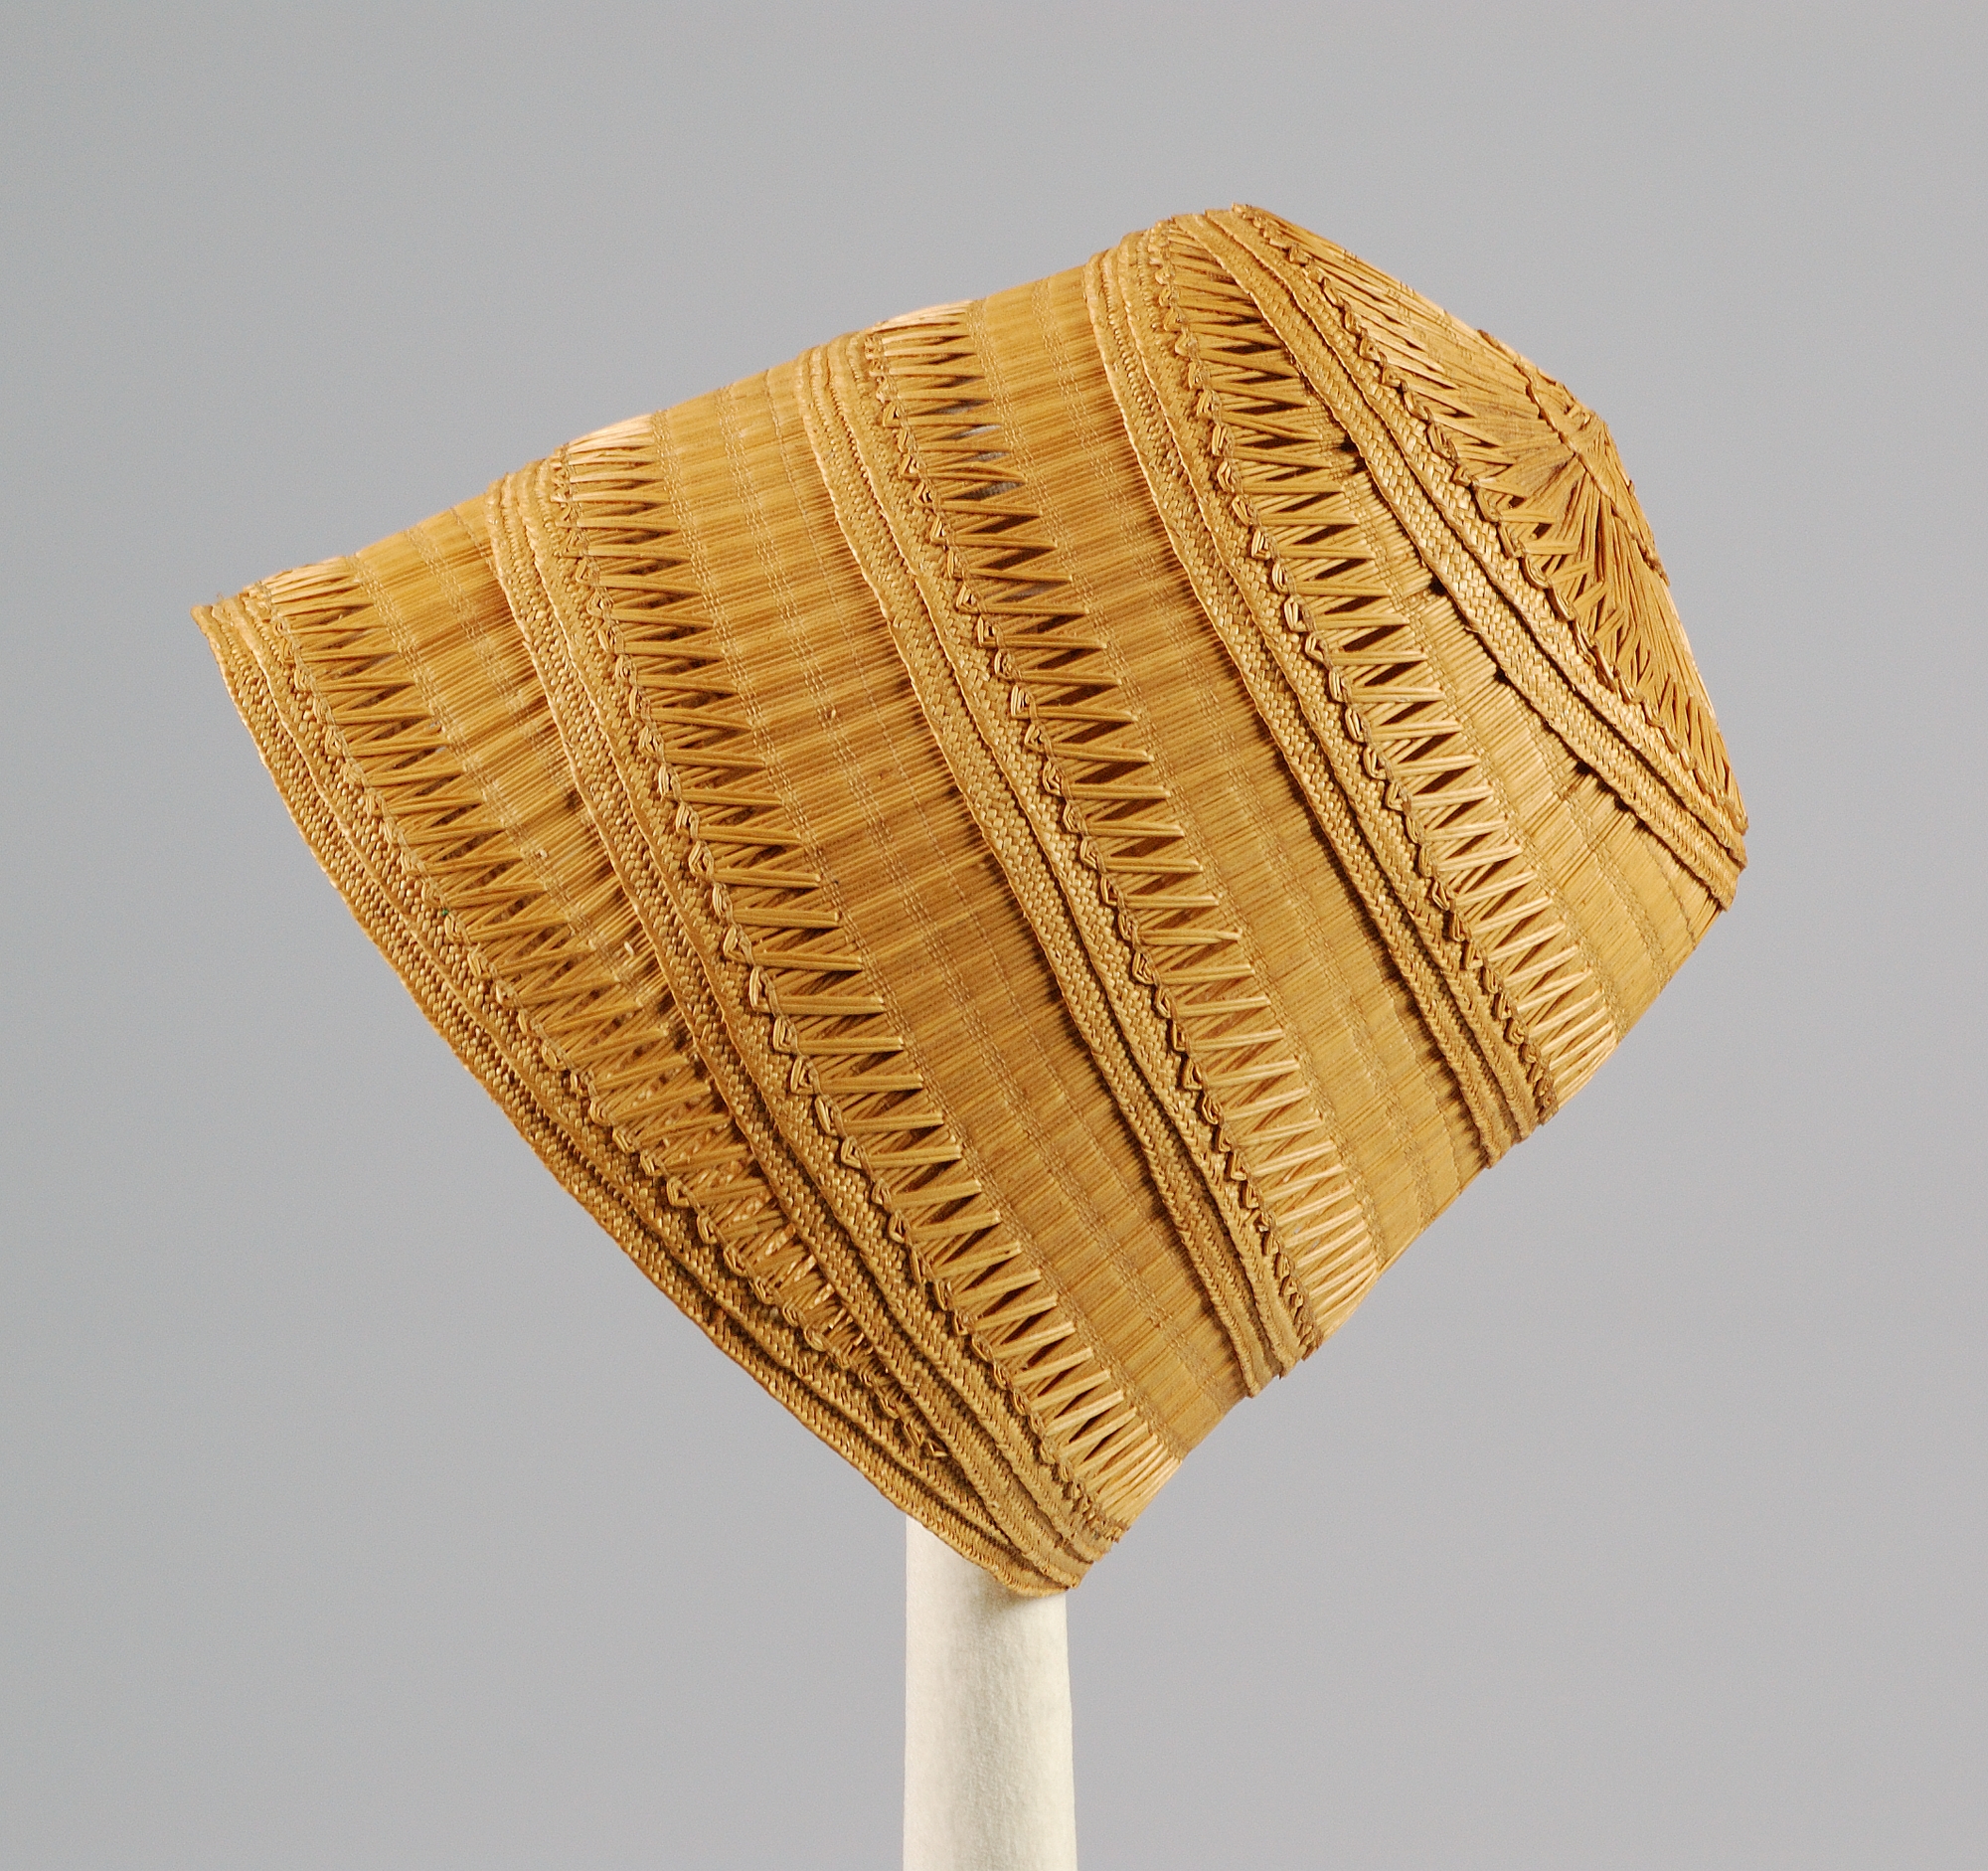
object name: hat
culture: american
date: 1810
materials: fiber